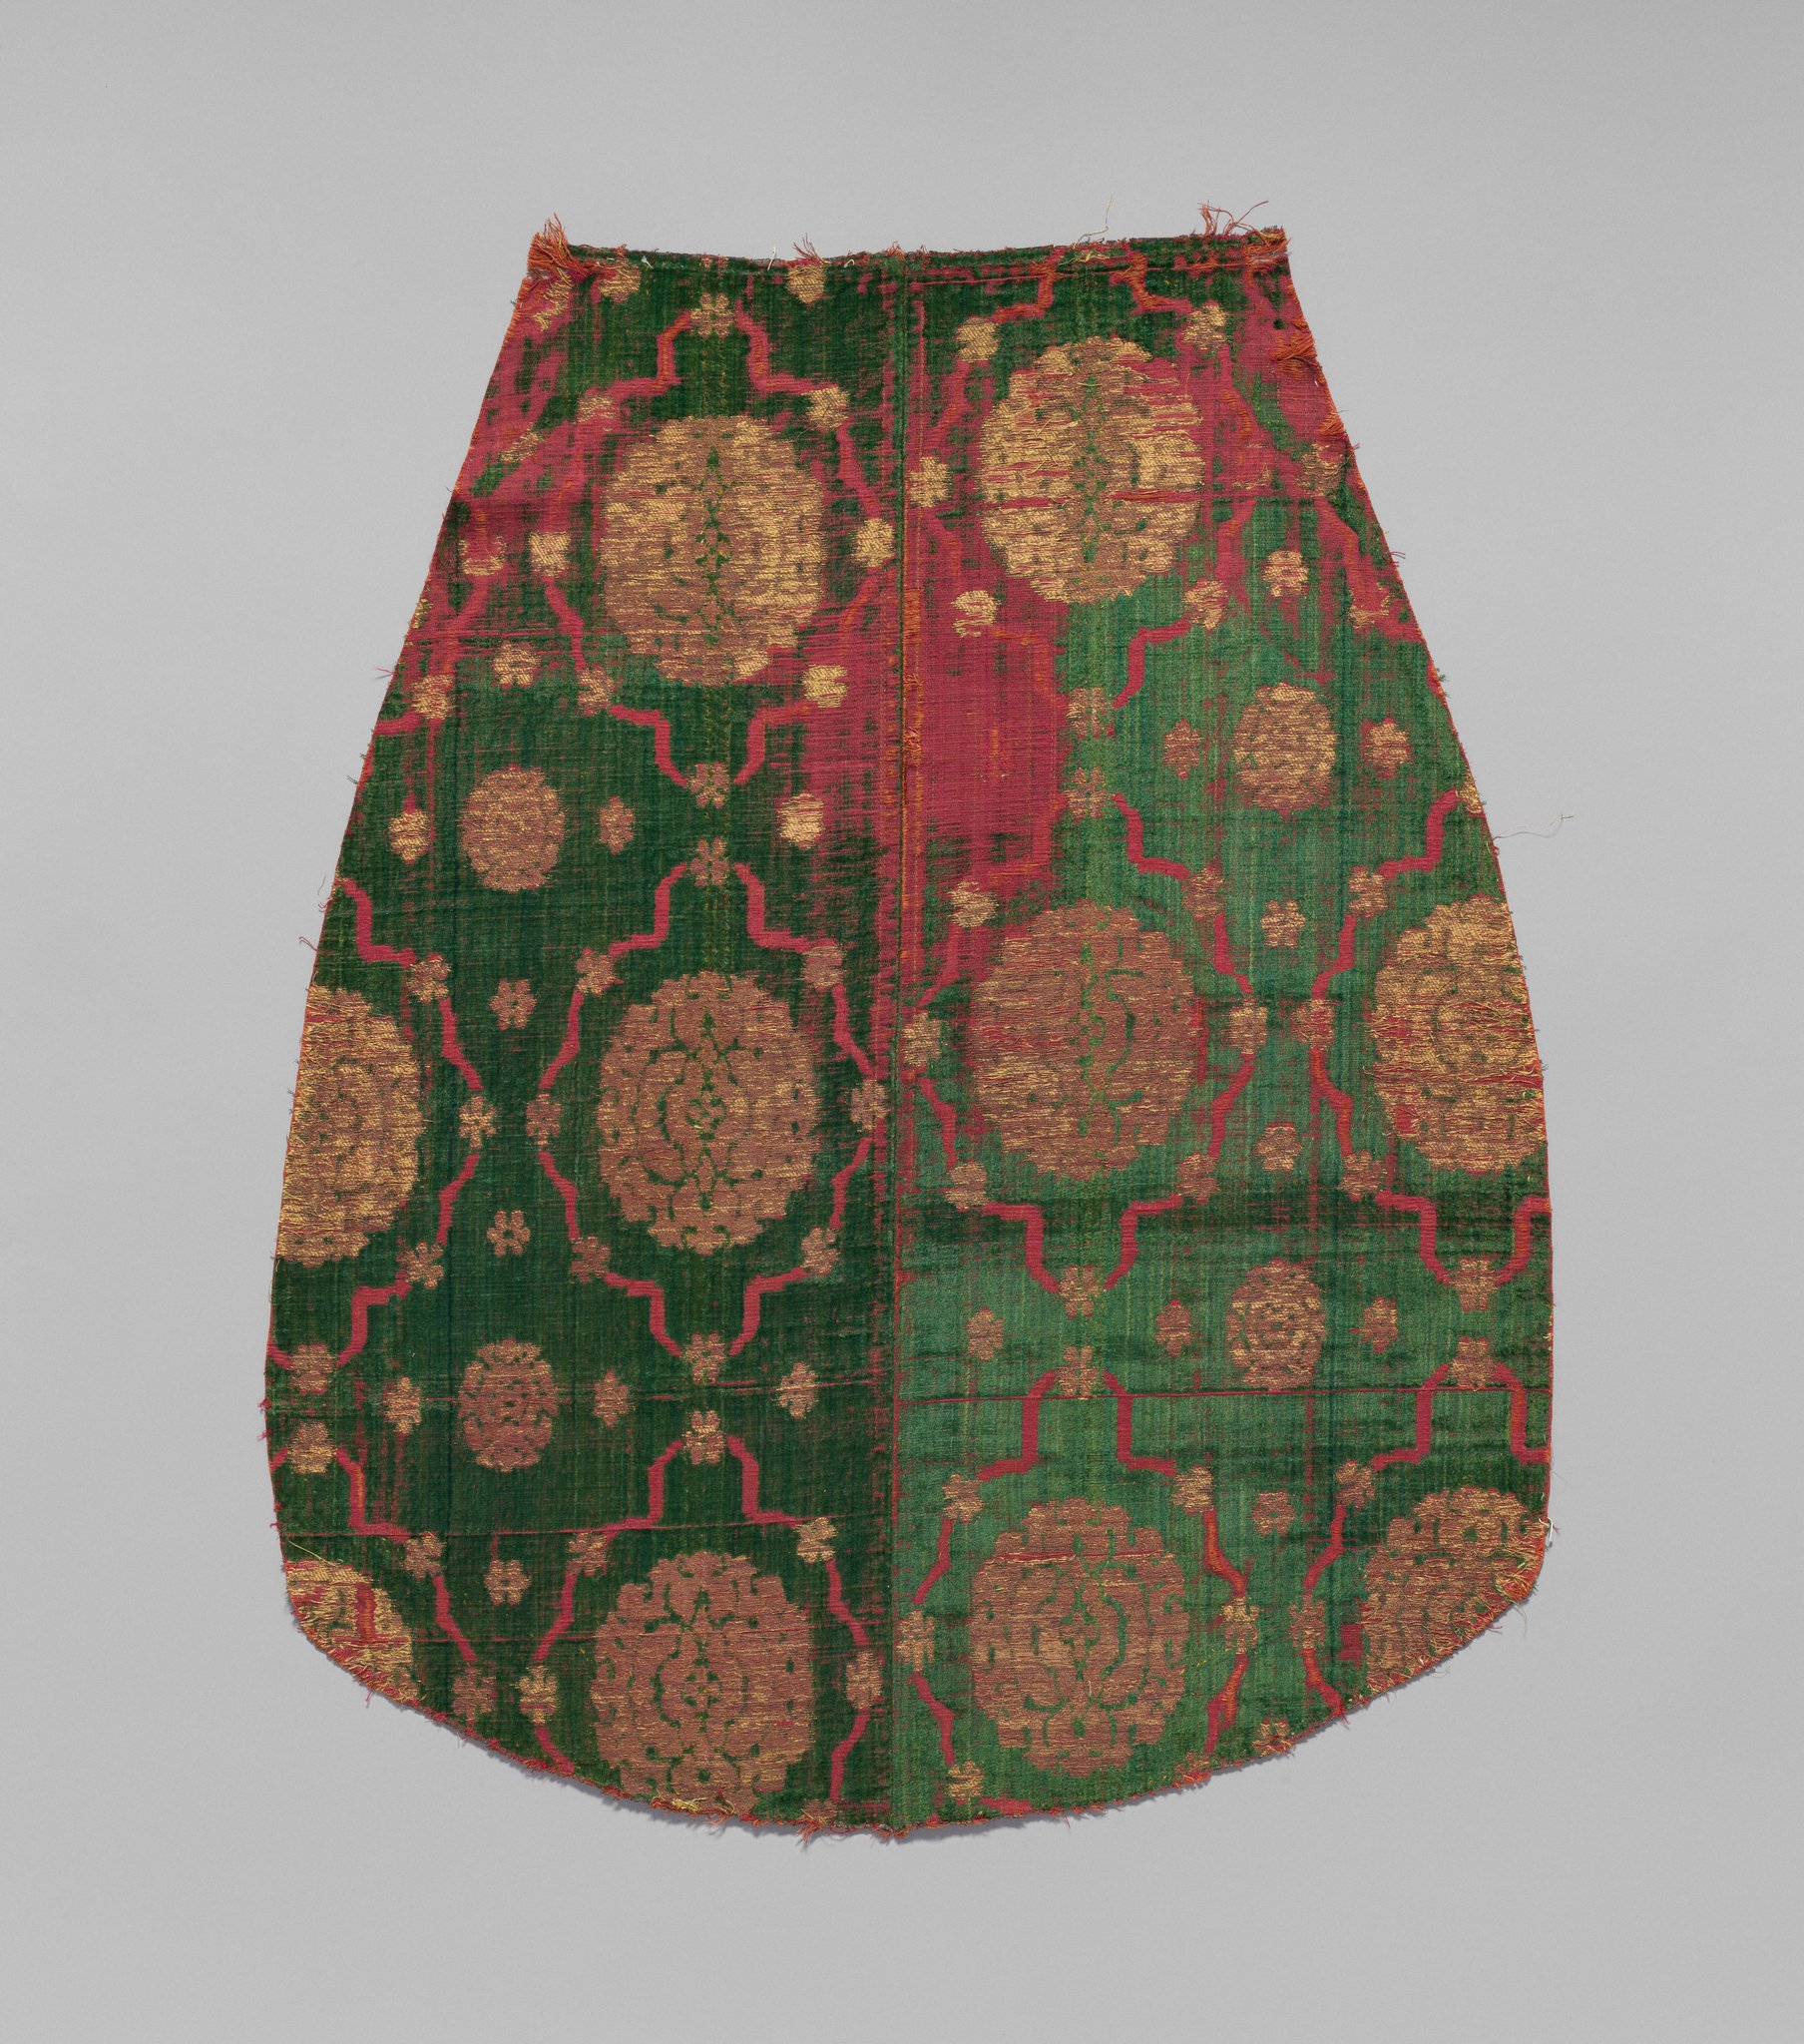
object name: fragment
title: Green and Crimson Cut Voided Satin Velvet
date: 1401-1500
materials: cotton, metal thread, silk